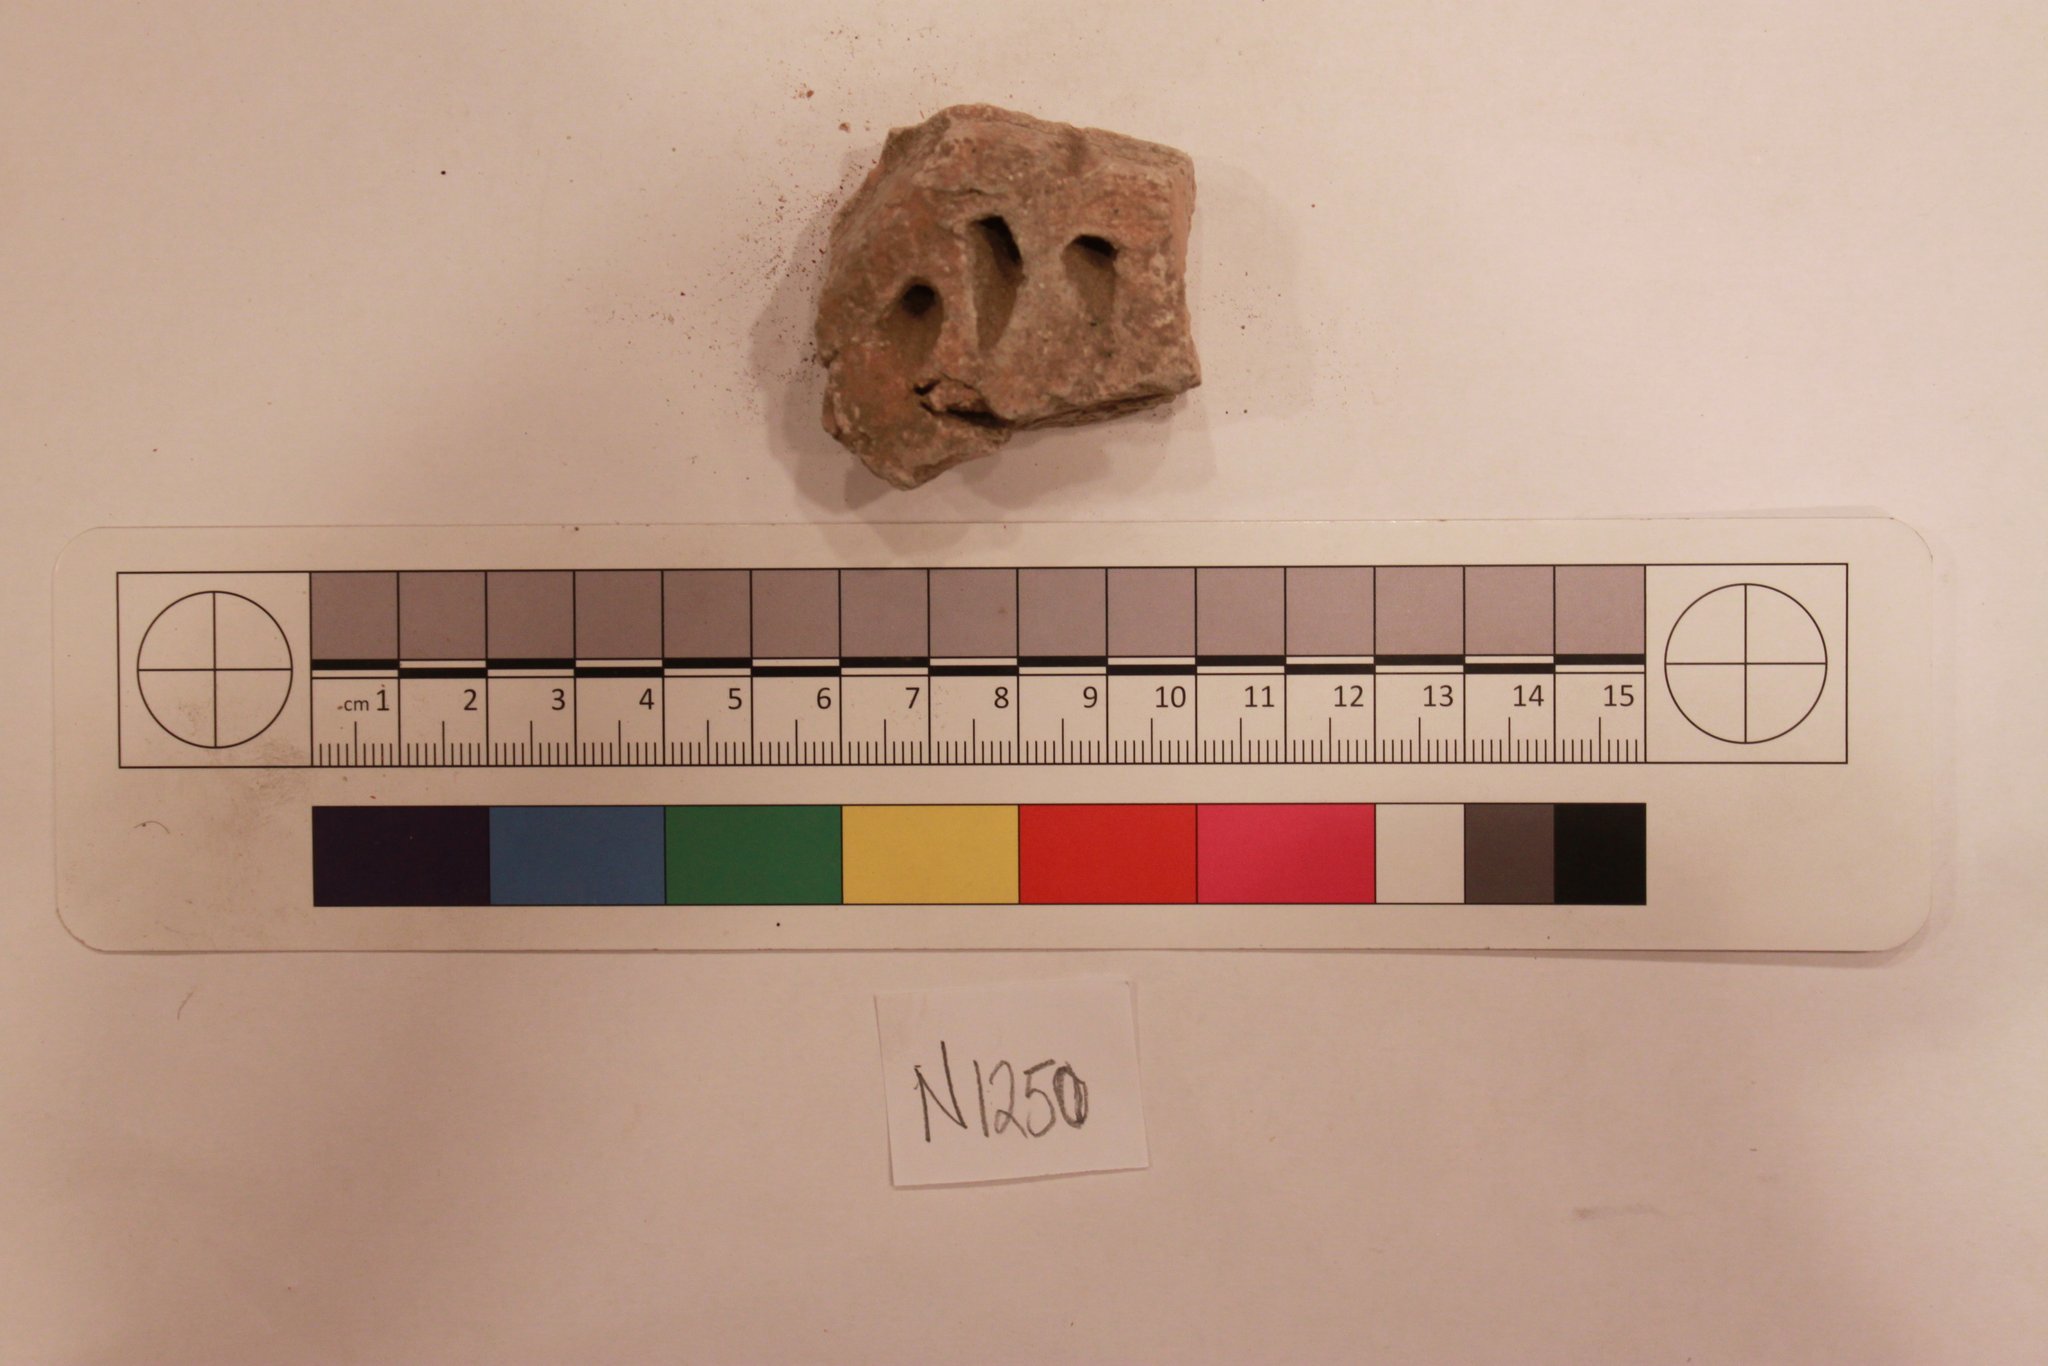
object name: fragment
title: Stucco Fragment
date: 701-1200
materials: plaster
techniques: carving, painting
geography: iran